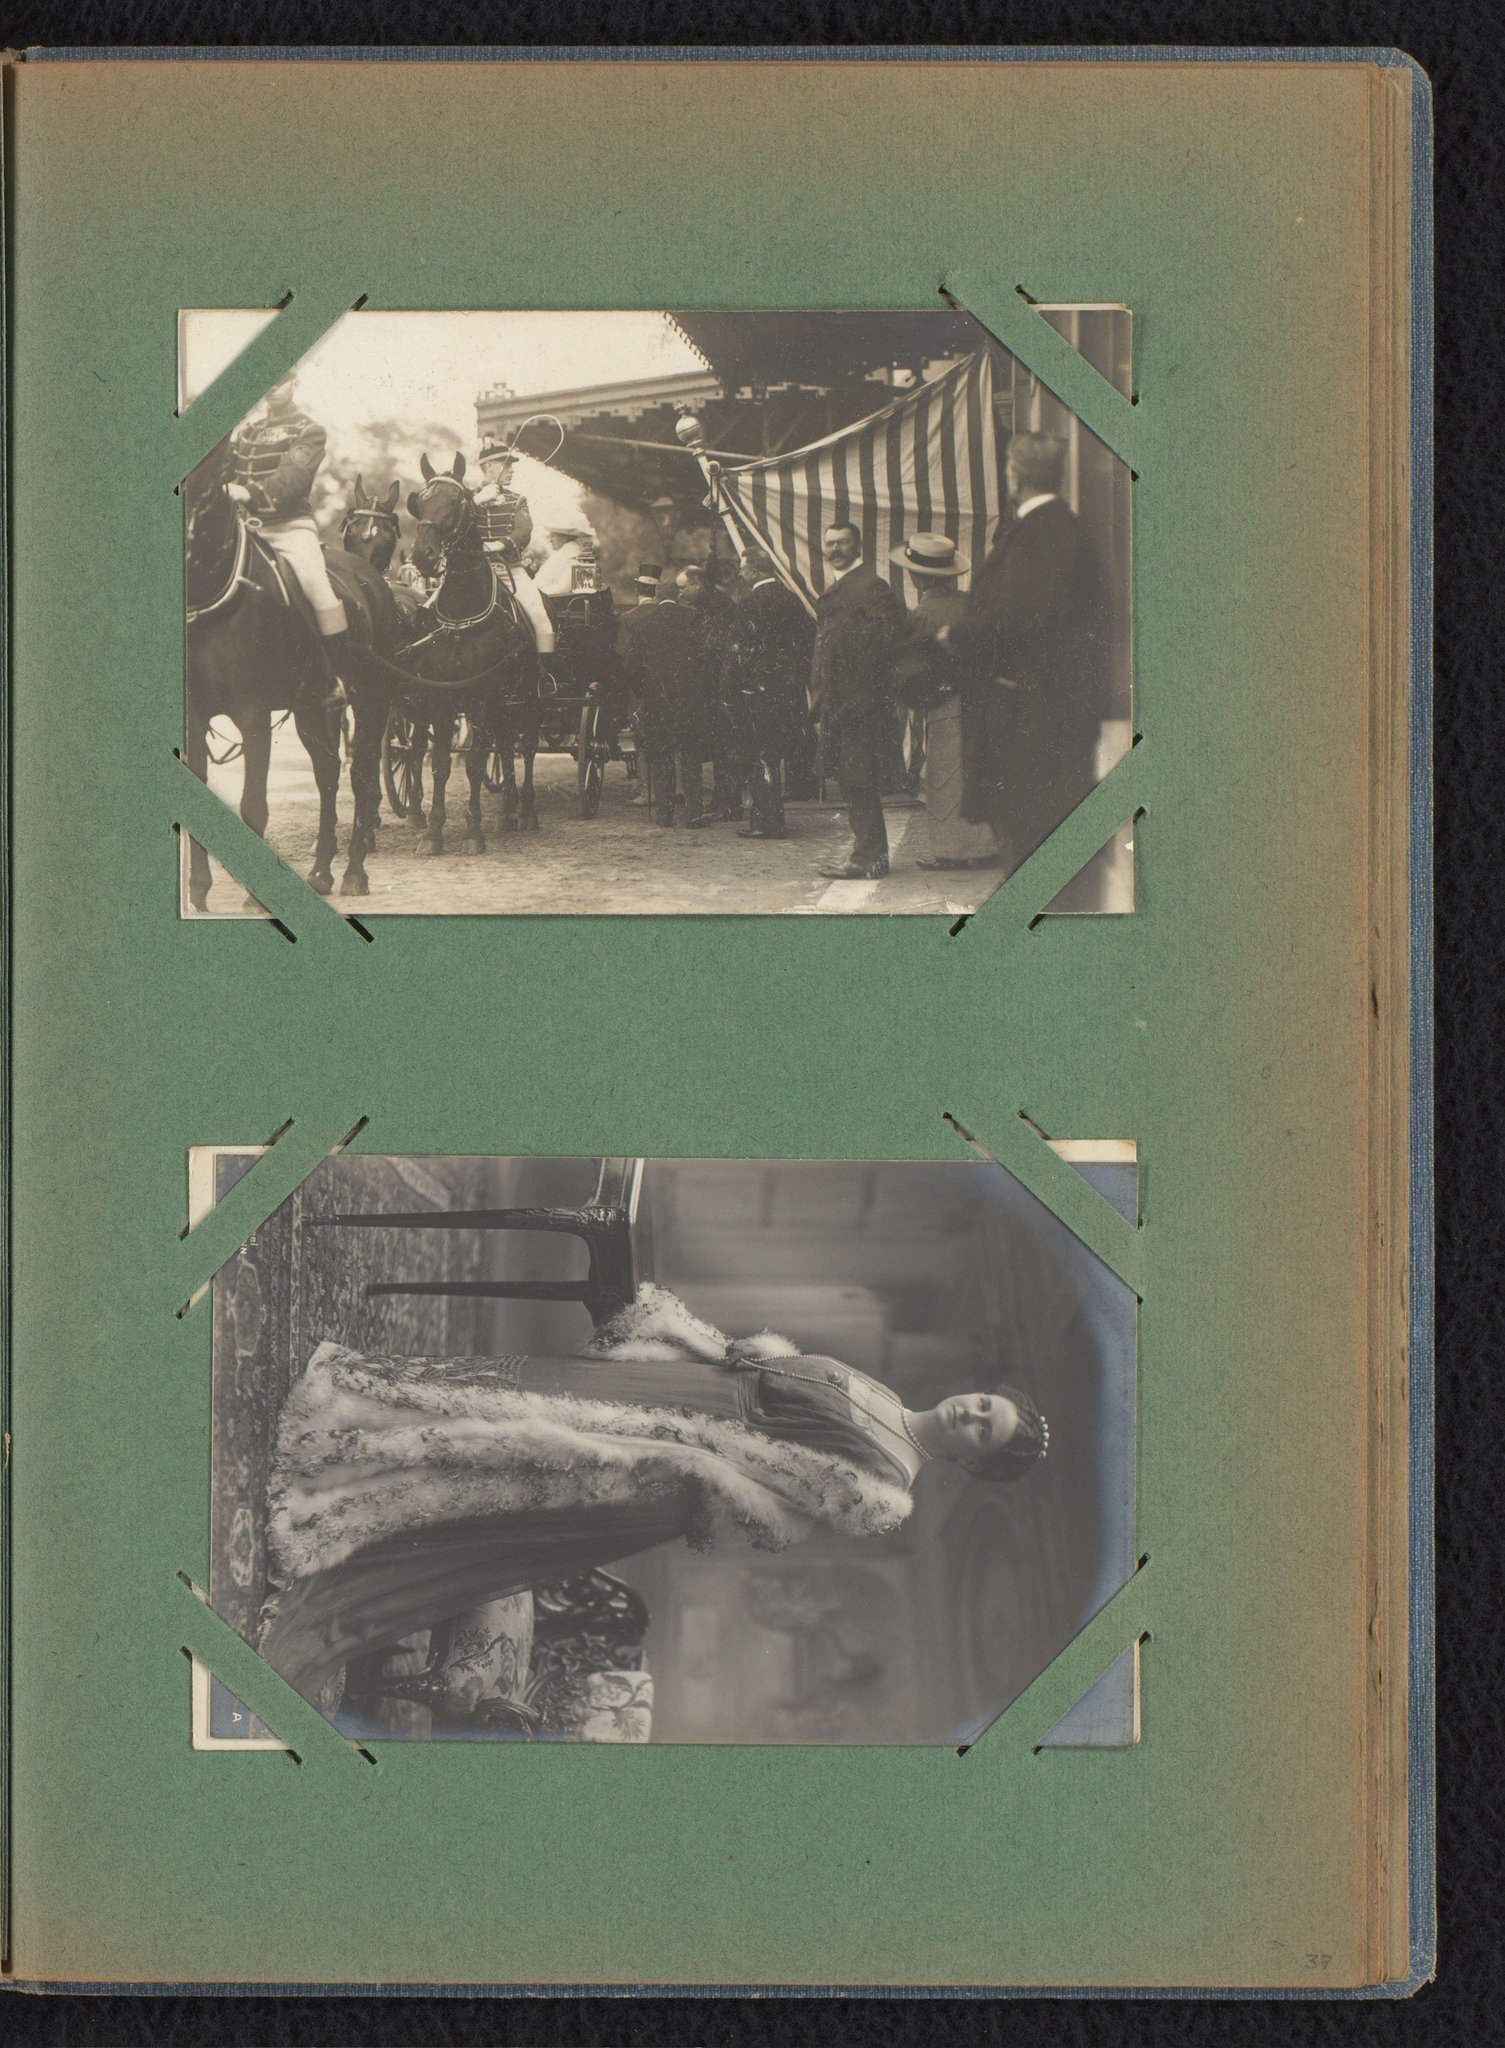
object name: photograph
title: Twee prentbriefkaarten van een rijtoer en een portret van koningin Wilhelmina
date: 1912-1925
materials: paper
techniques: gelatin silver print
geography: the hague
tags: wilhelmina of the netherlands, historical persons - bb - woman, queen, four-wheeled vehicle drawn by two animals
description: Deze foto's maken deel uit van een album.